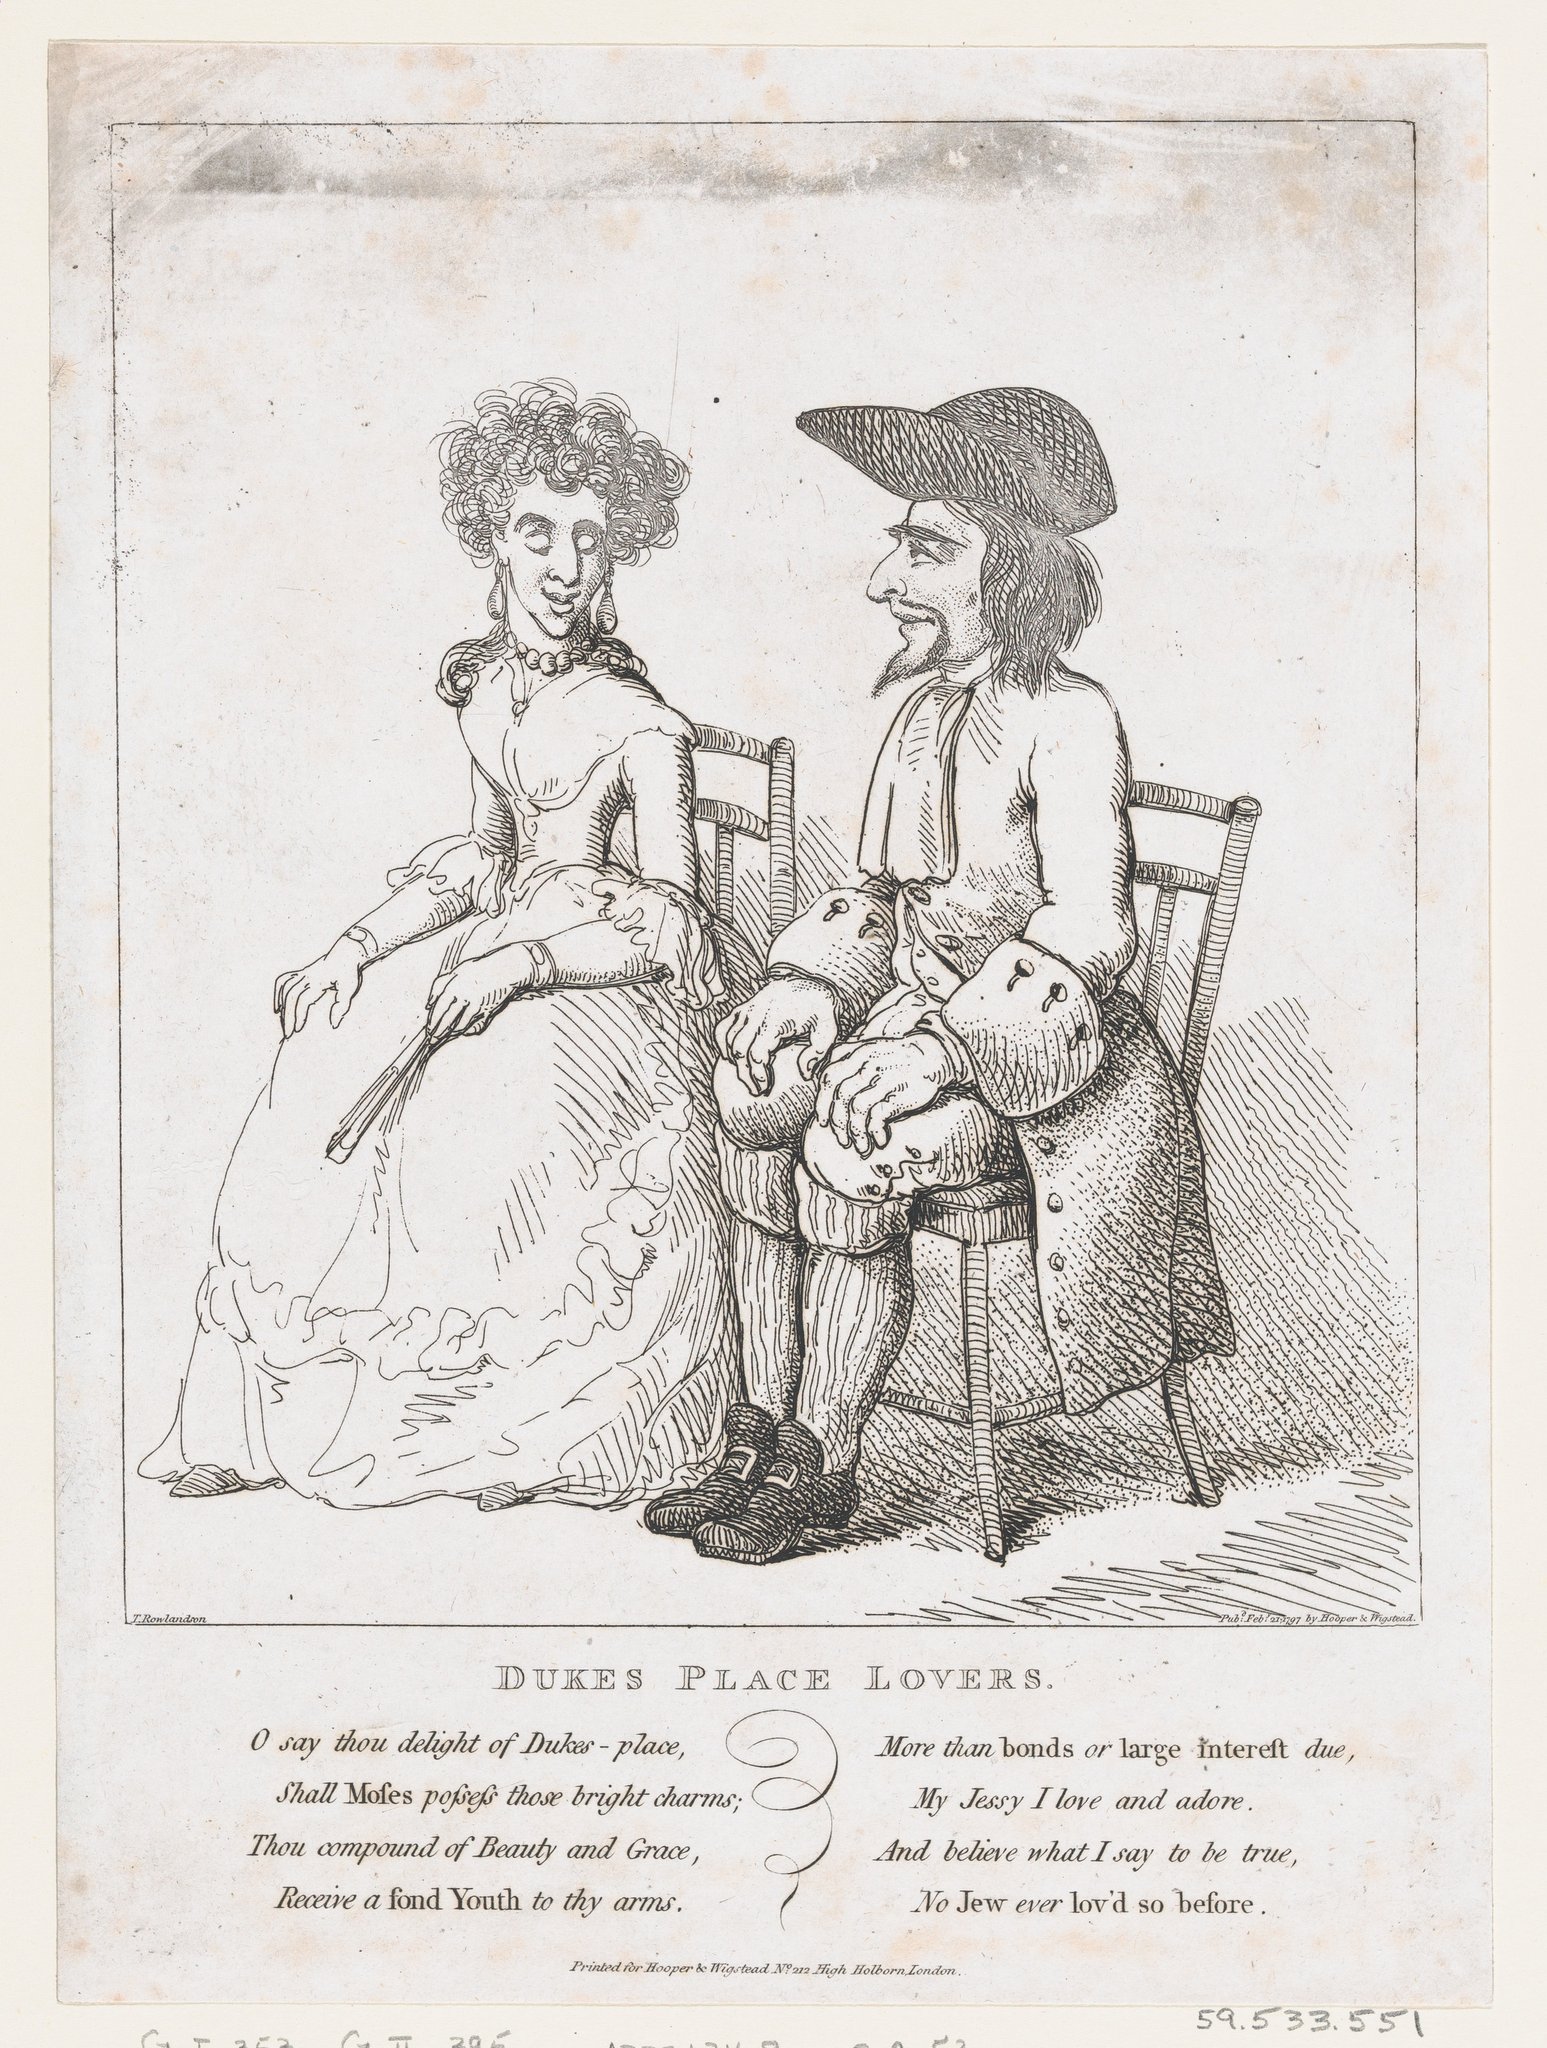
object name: print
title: Dukes Place Lovers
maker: thomas rowlandson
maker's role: artist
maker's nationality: british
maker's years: 1757-1827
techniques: etching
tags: men,lovers,women